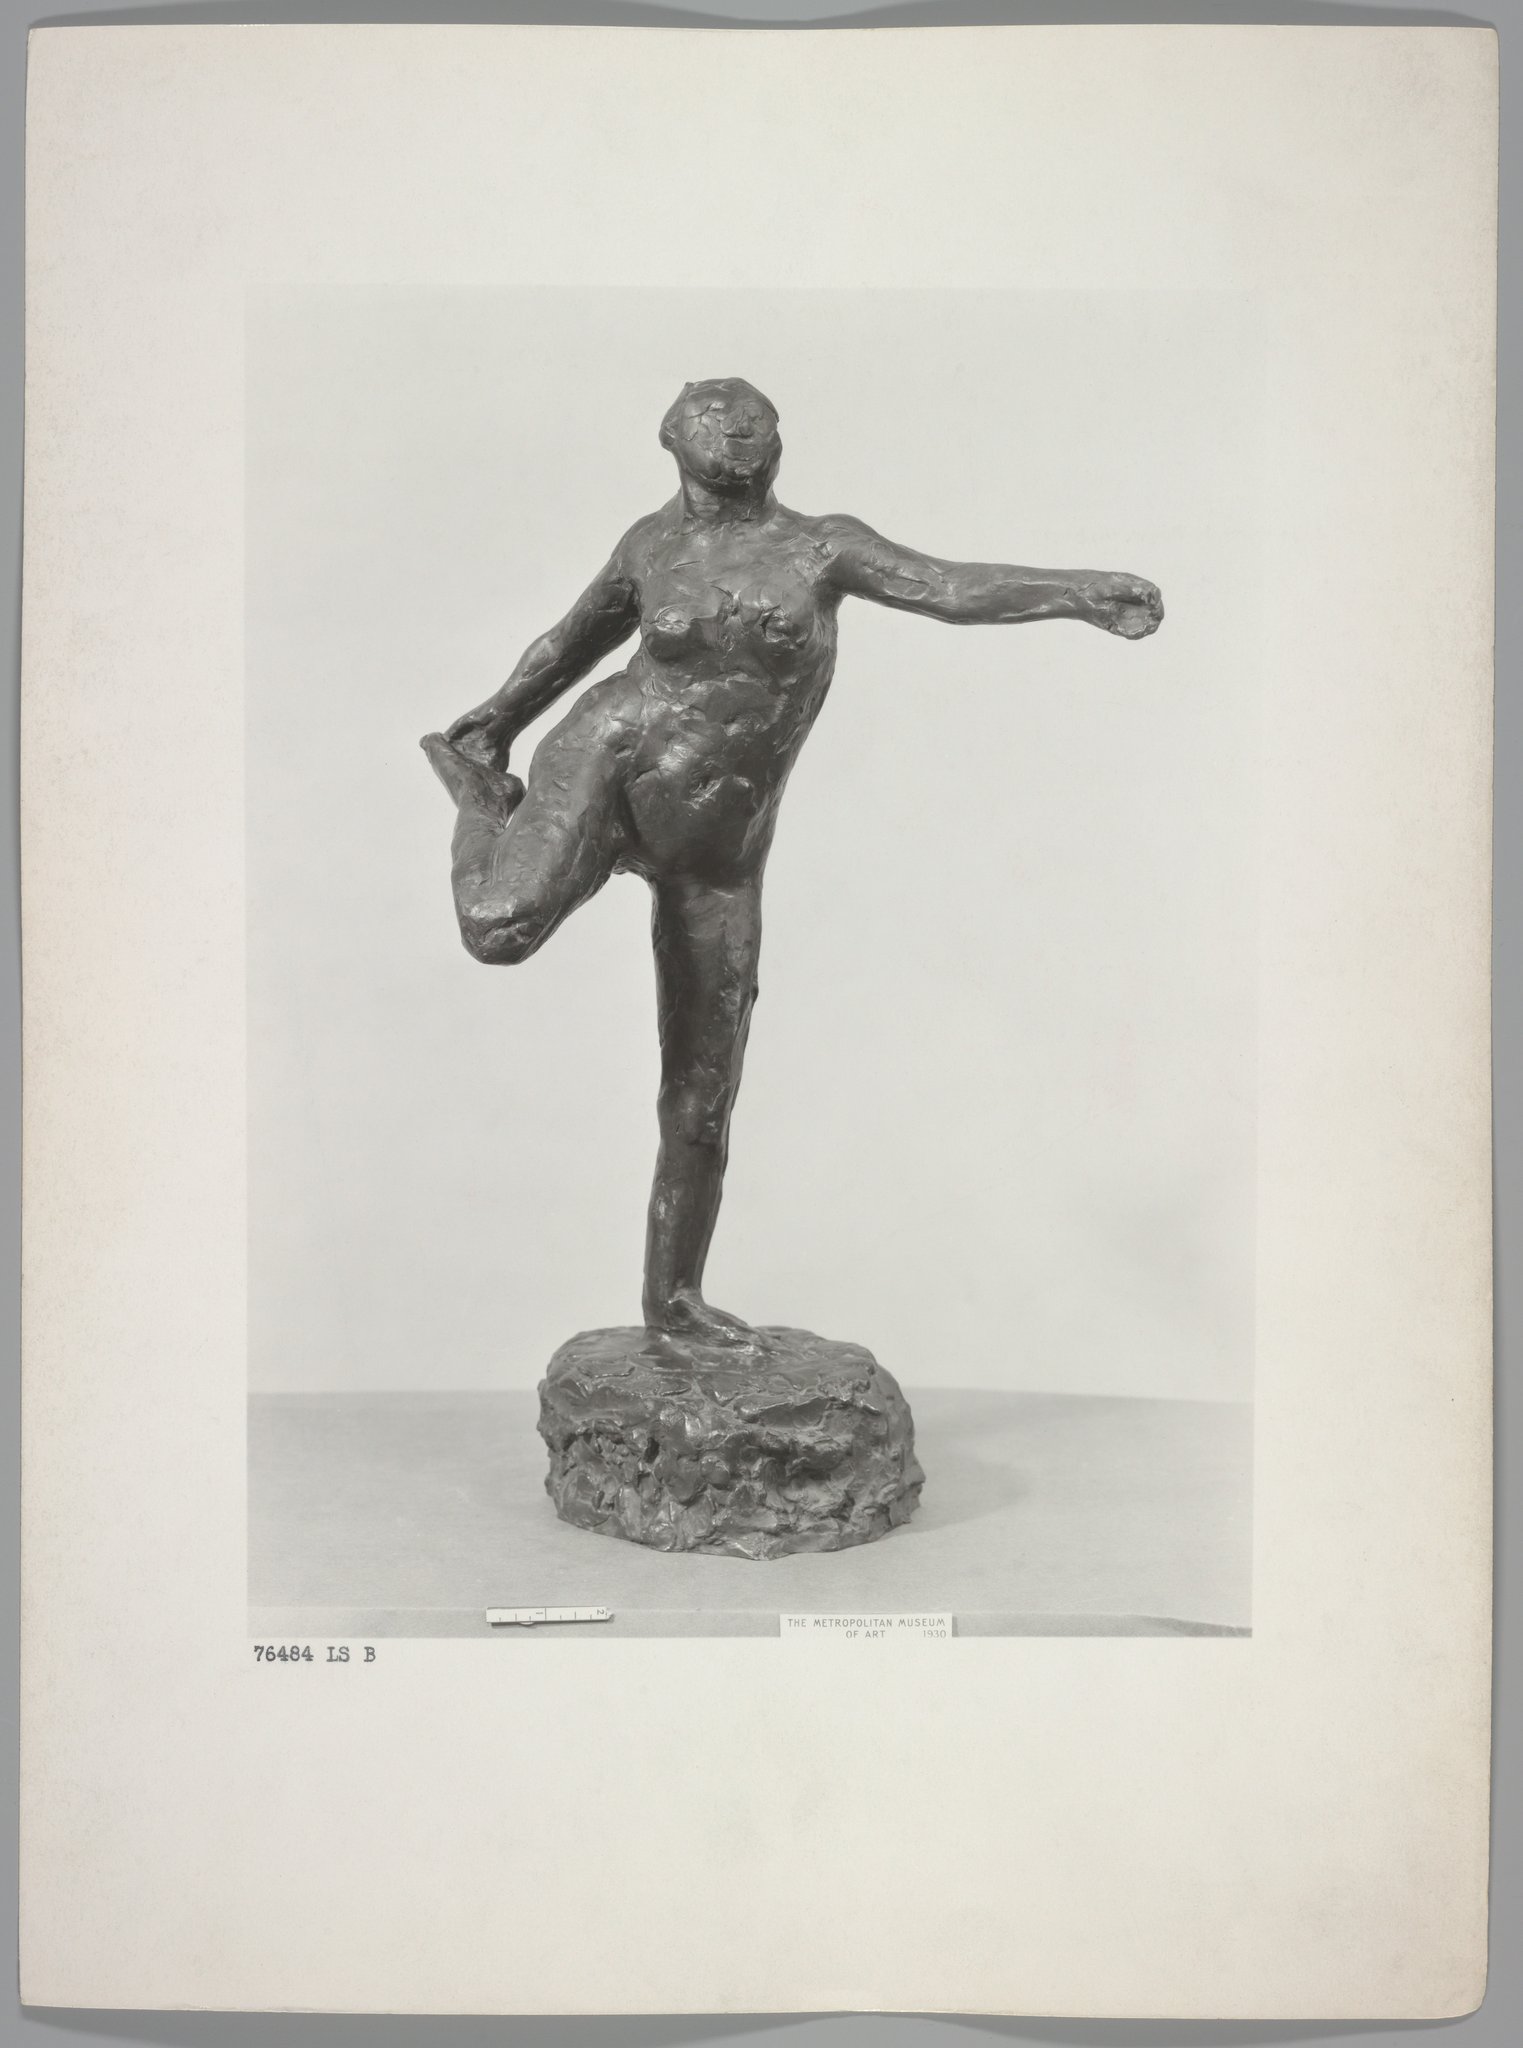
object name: statuette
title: Dancer Holding Her Right Foot in Her Right Hand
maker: edgar degas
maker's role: artist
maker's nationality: french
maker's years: 1834-1917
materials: bronze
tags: female nudes,dancers